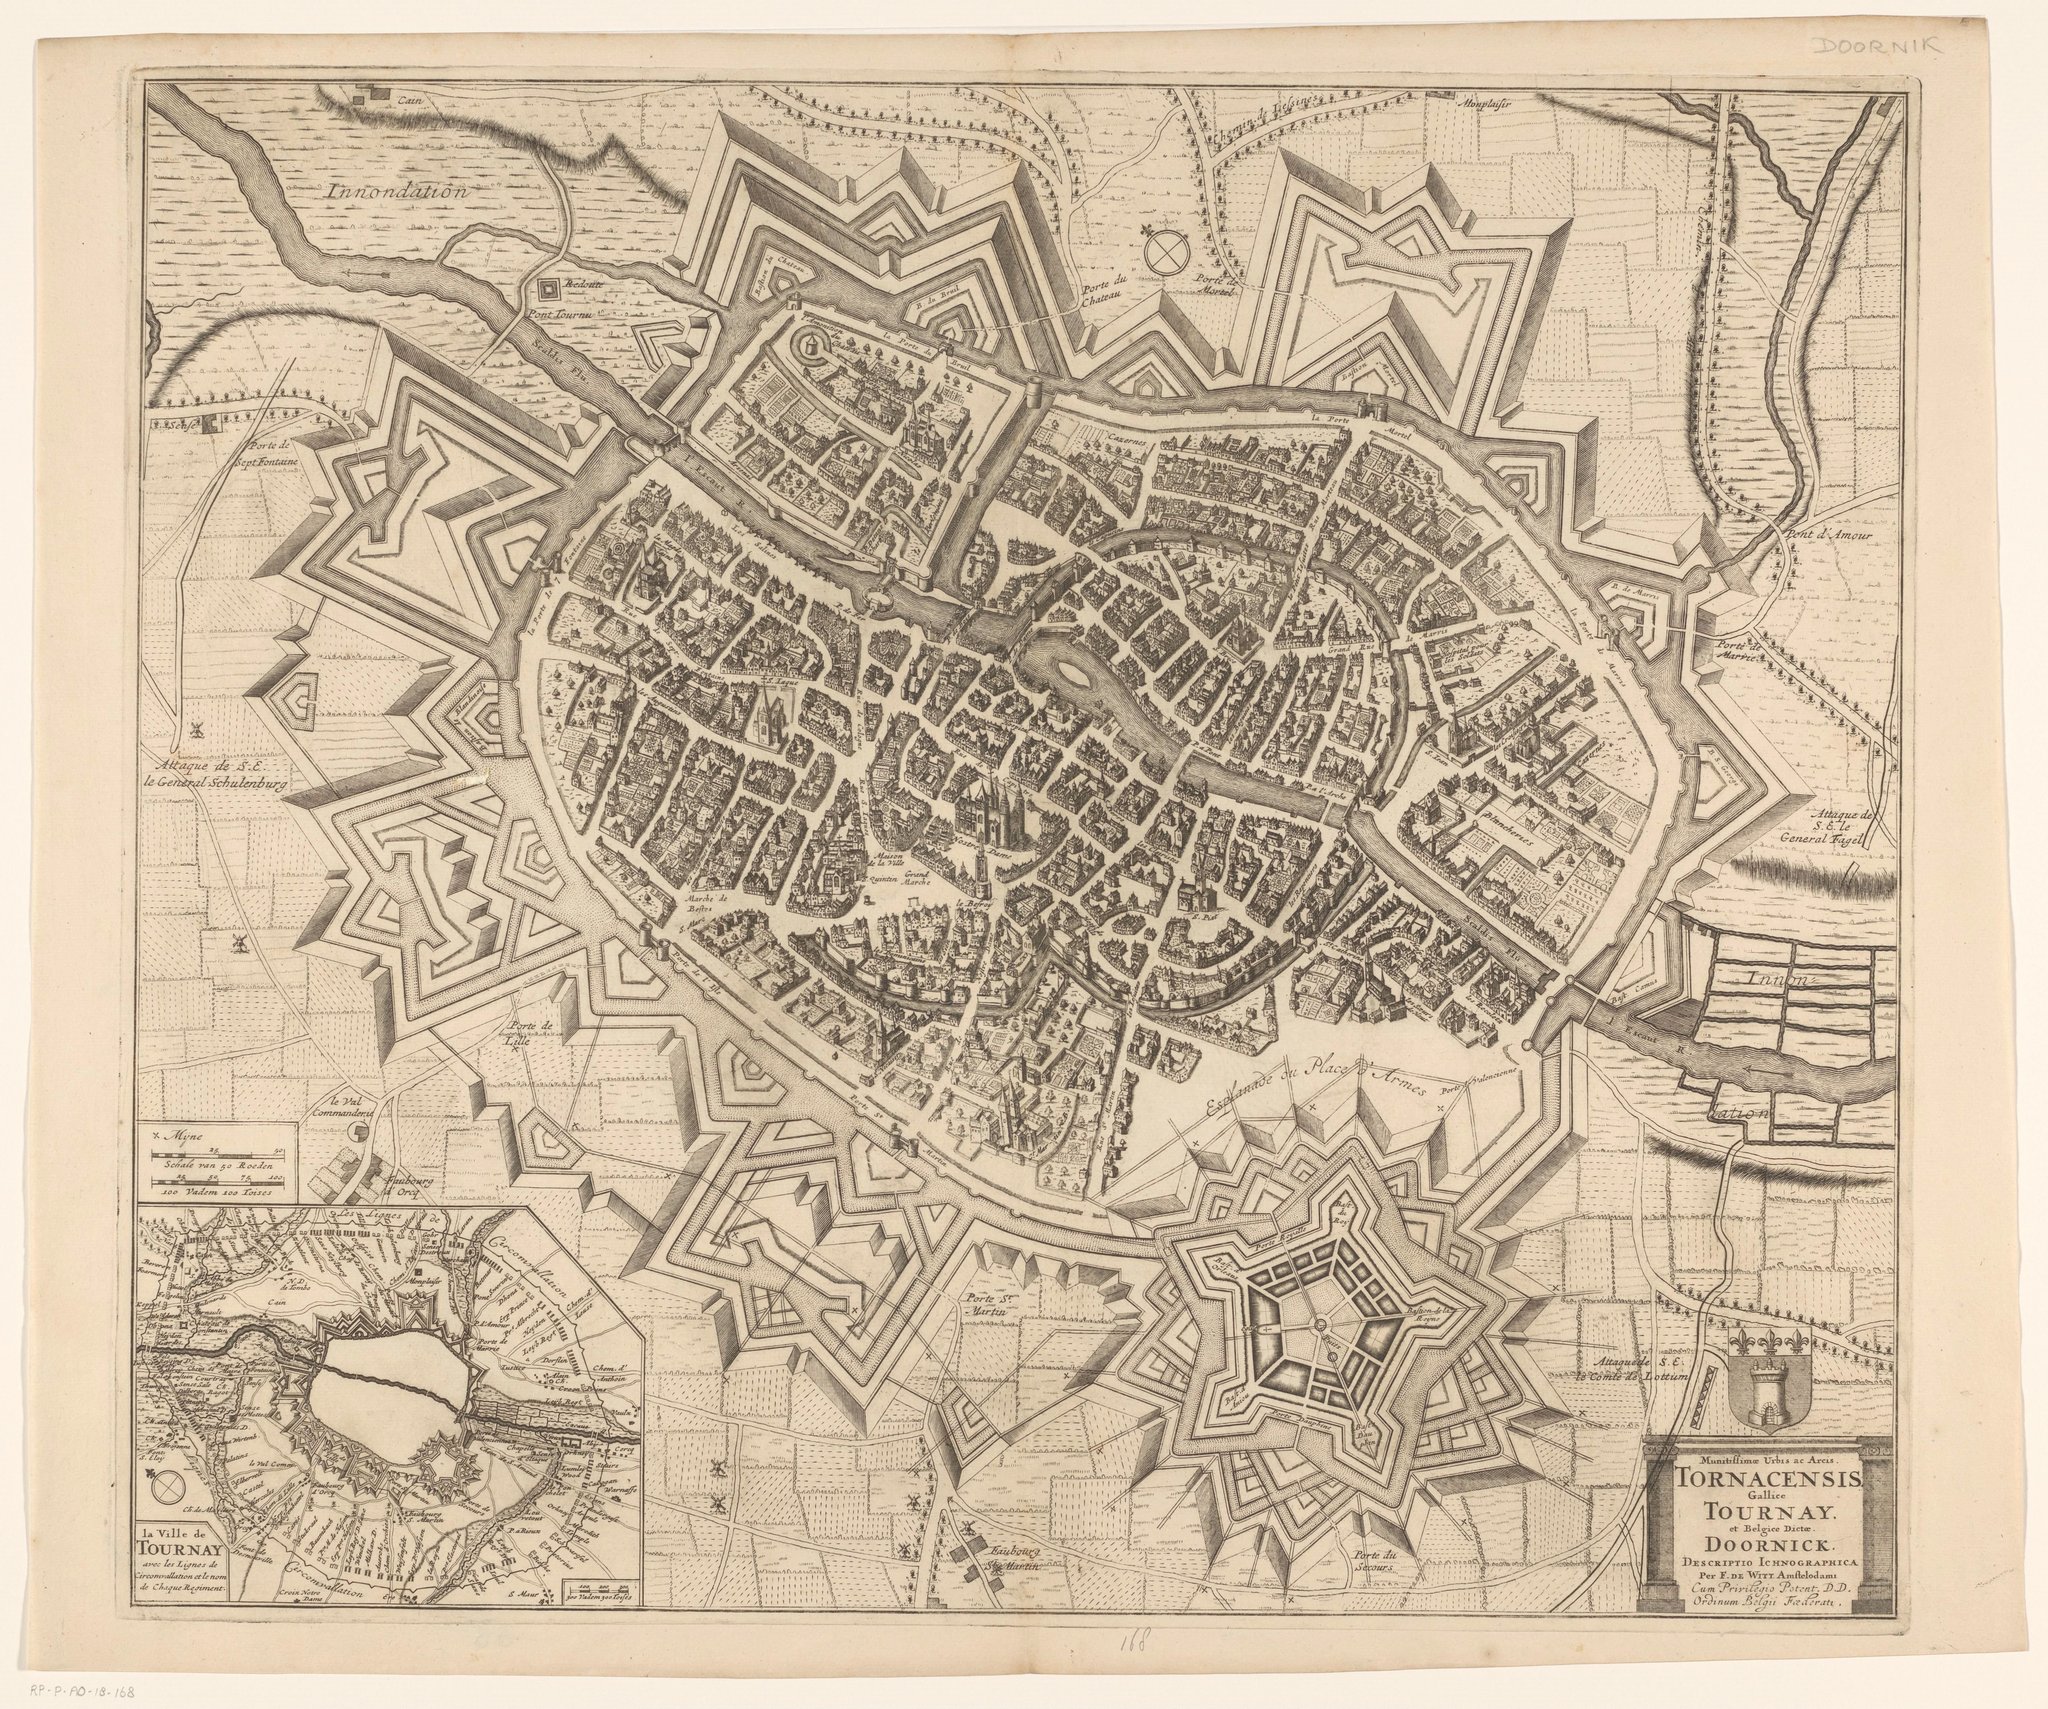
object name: area plan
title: Munitissimae urbis ac arcis Tornacensis, Gallice, Tournay (...)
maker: Anonymous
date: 1698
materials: paper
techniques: engraving, etching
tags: coat of arms (as symbol of the state, etc.) (+ city; municipal), maps of separate countries or regions, fortified city, maps of cities, siege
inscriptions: collector's mark: Lugt 195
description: Plattegrond van de stad Doornik tijdens het beleg van 1709, met gebouwen in vogelvluchtperspectief. Rechtsonder de titelcartouche met daarboven het wapen van Doornik. Linksonder een inzet met een kaart van de omgeving van Doornik, met daarop de linies van het beleg. Hierboven een kader met twee schaalstokken: Schale van 50 Roeden / 100 Vadem 100 Toises.